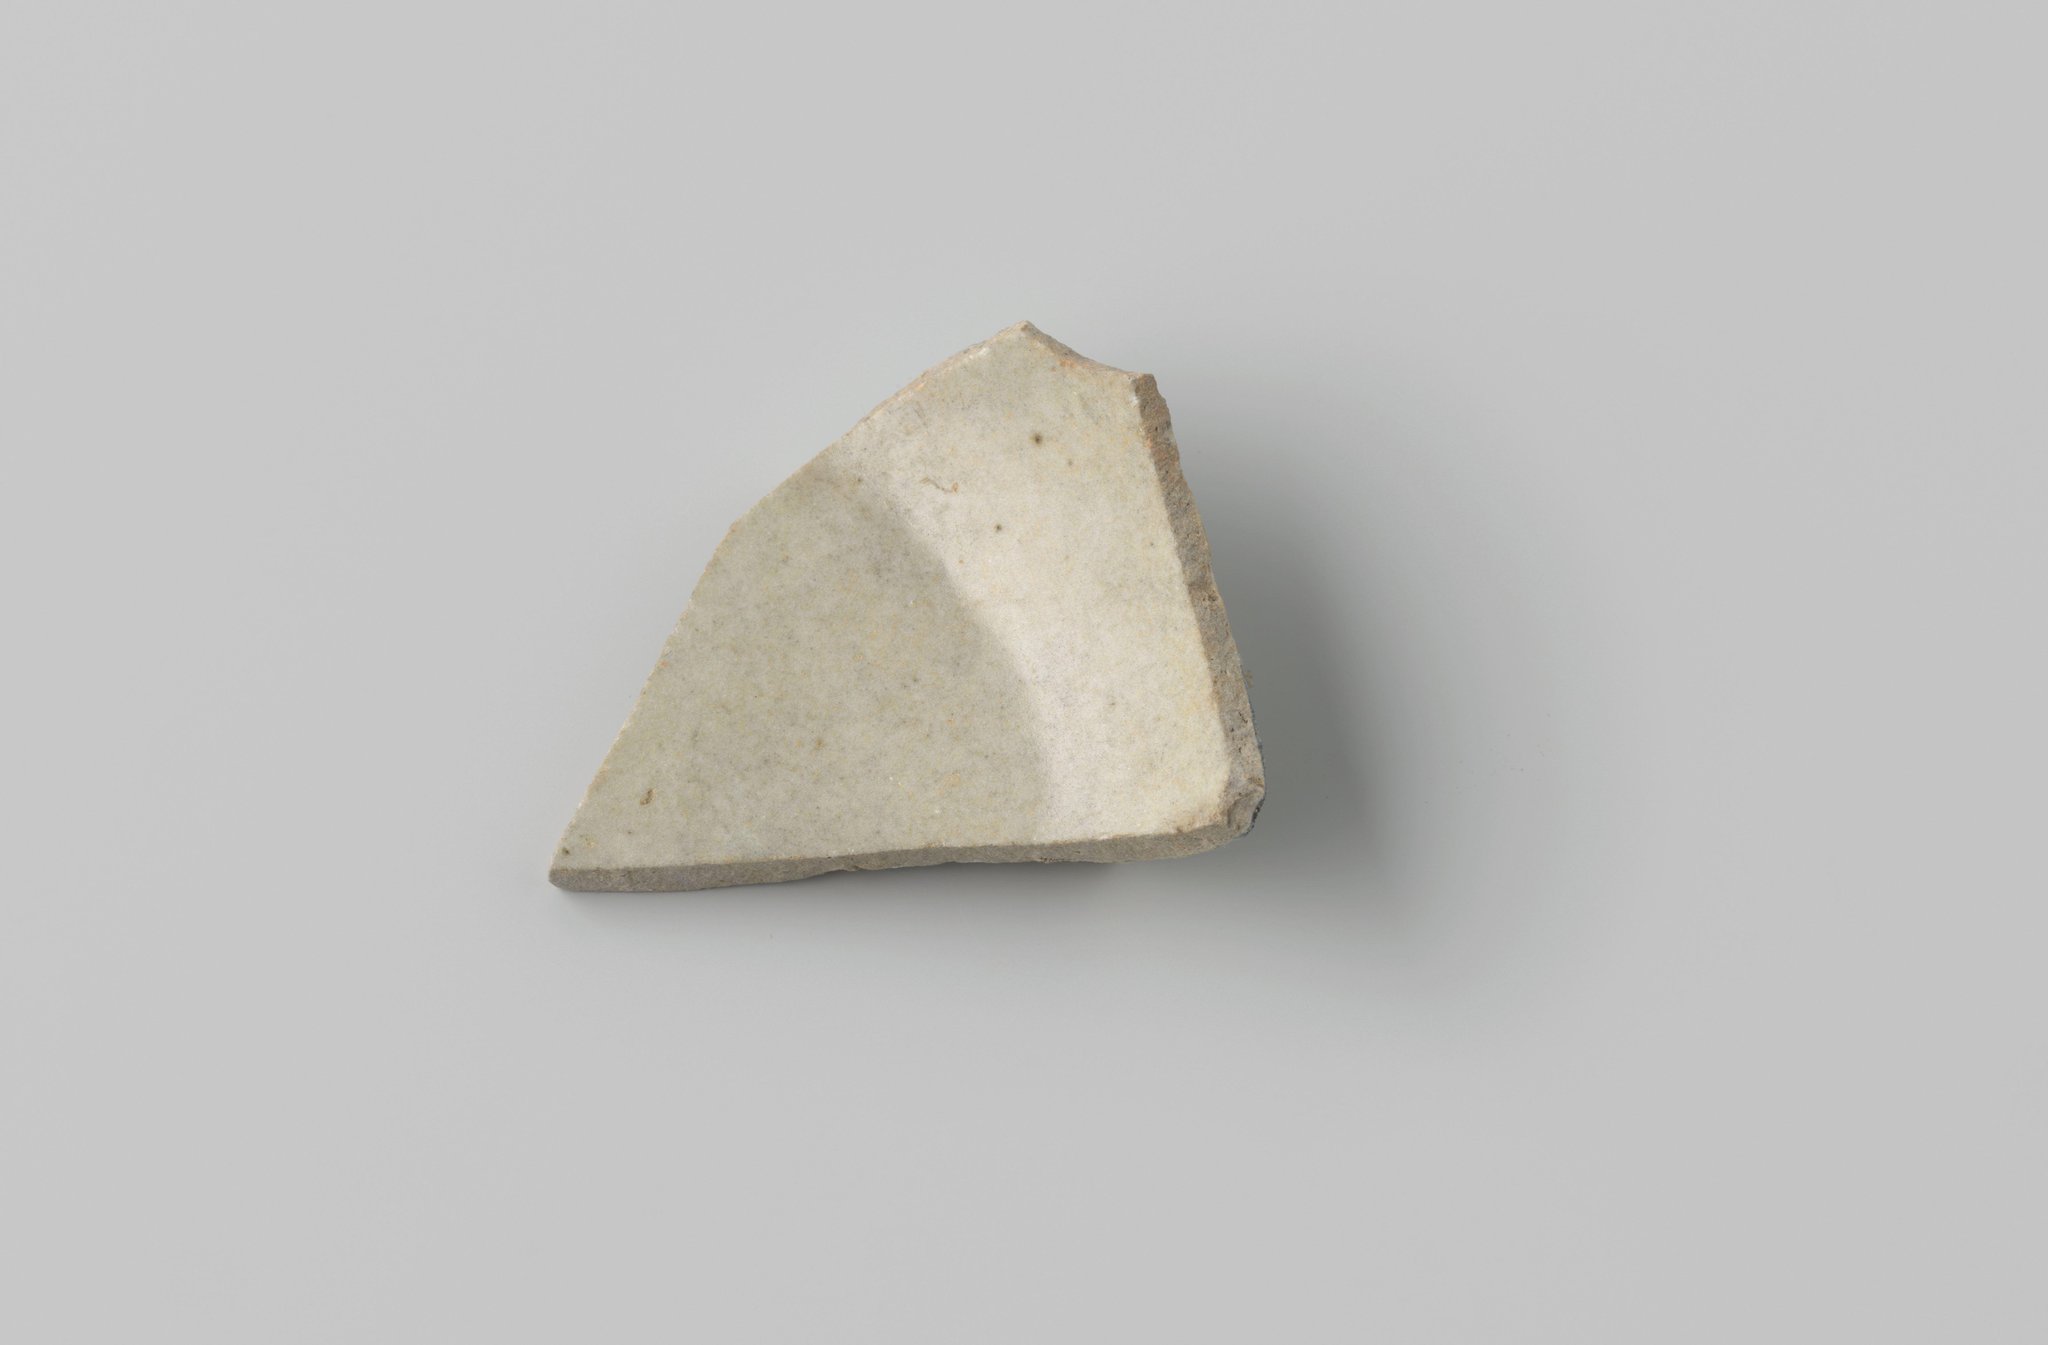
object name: bowl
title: Scherf van een kom uit V.O.C.-schip de 'Witte Leeuw'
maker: Anonymous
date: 1613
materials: porcelain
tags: verenigde oostindische compagnie, sint-helena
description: Scherf van een kom uit V.O.C.-schip de 'Witte Leeuw'.